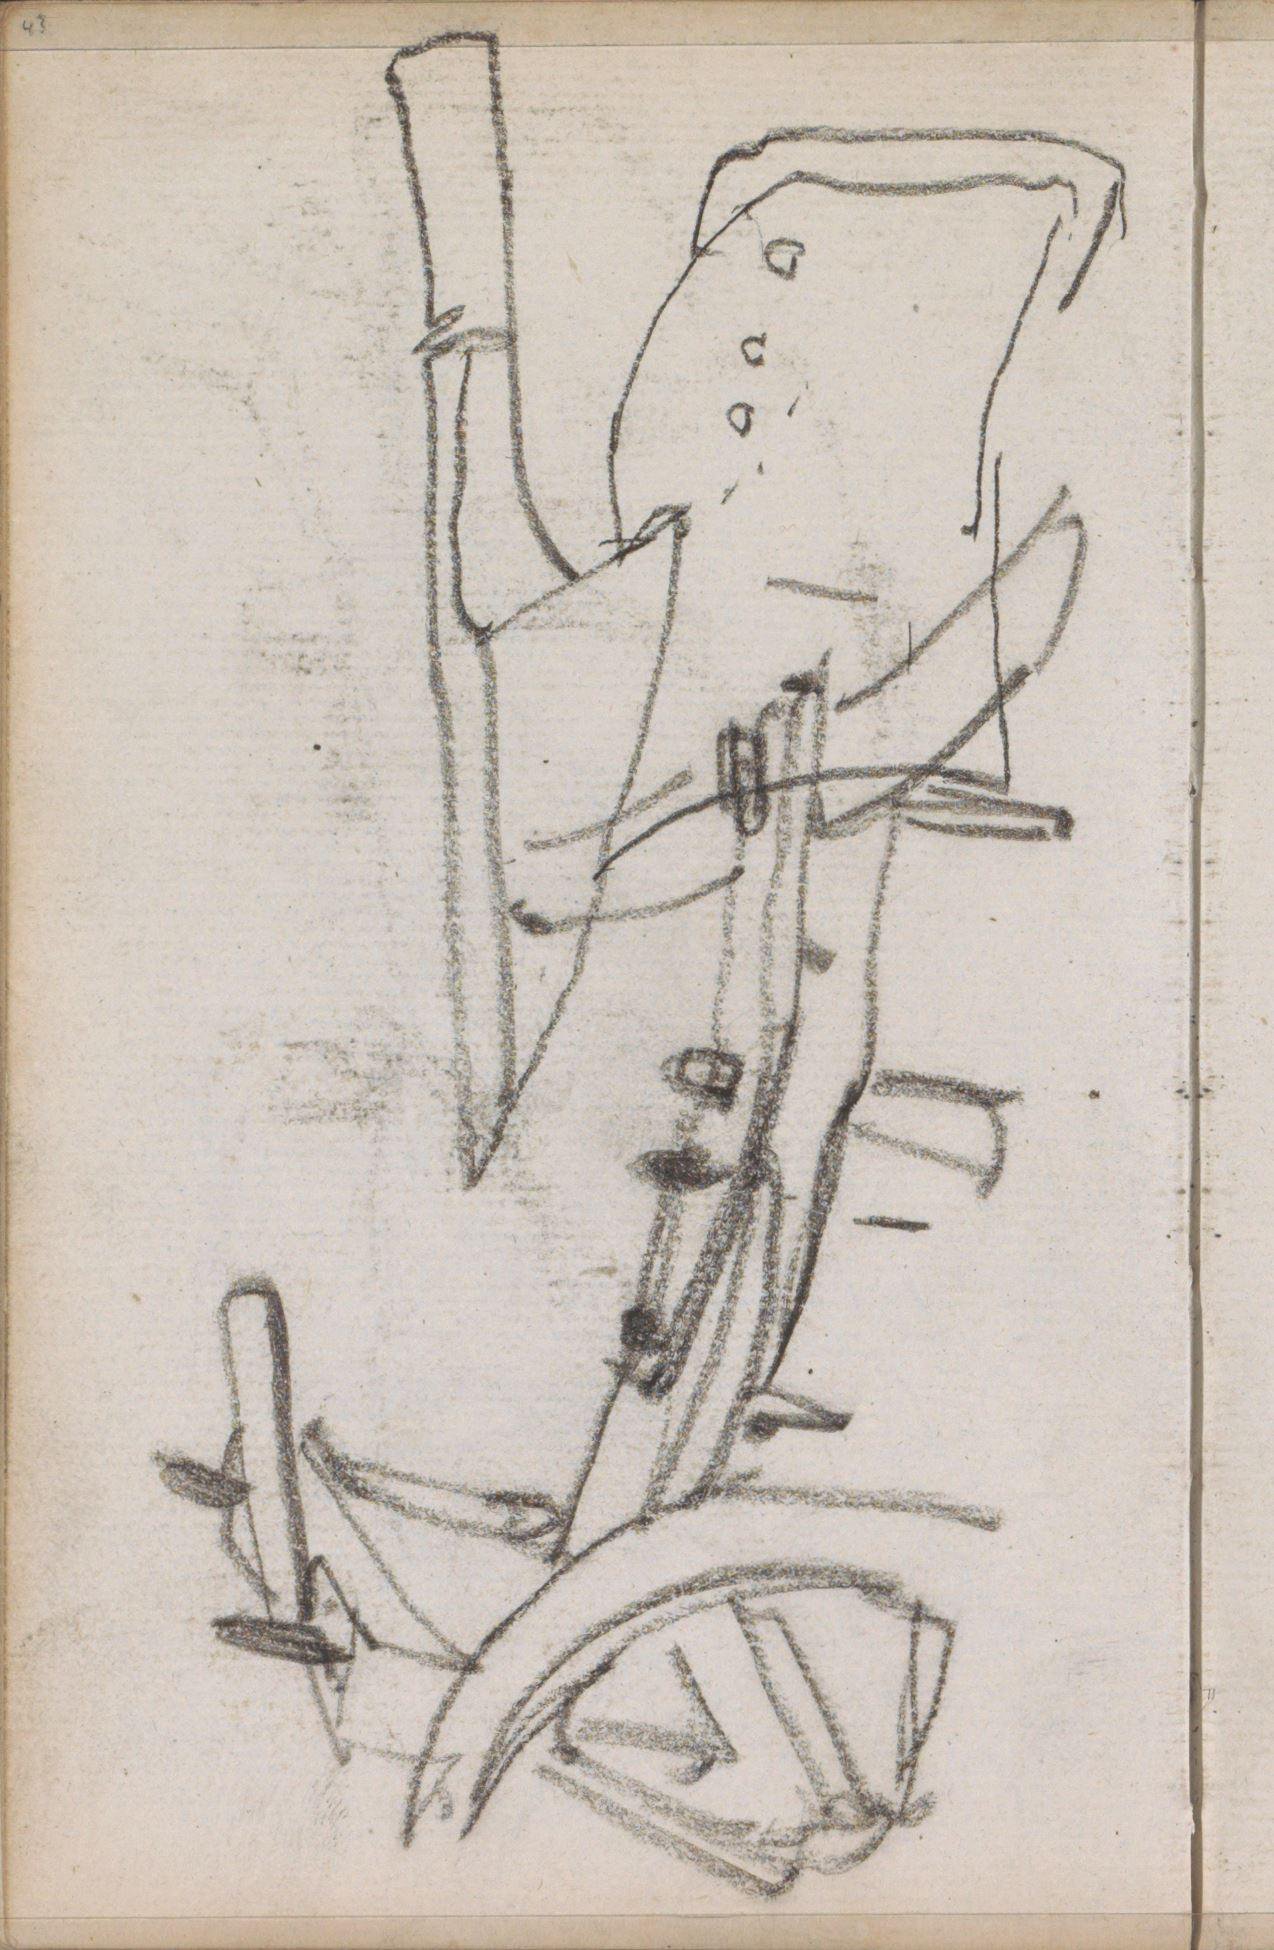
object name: sketchbook leaf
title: Ploeg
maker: george hendrik breitner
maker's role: draughtsman, painter, print maker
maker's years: 1857-1923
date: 1884-1886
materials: chalk, paper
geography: drenthe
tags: agricultural implements: plough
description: Pagina 43 uit een schetsboek met 67 bladen vervaardigd in Drenthe.